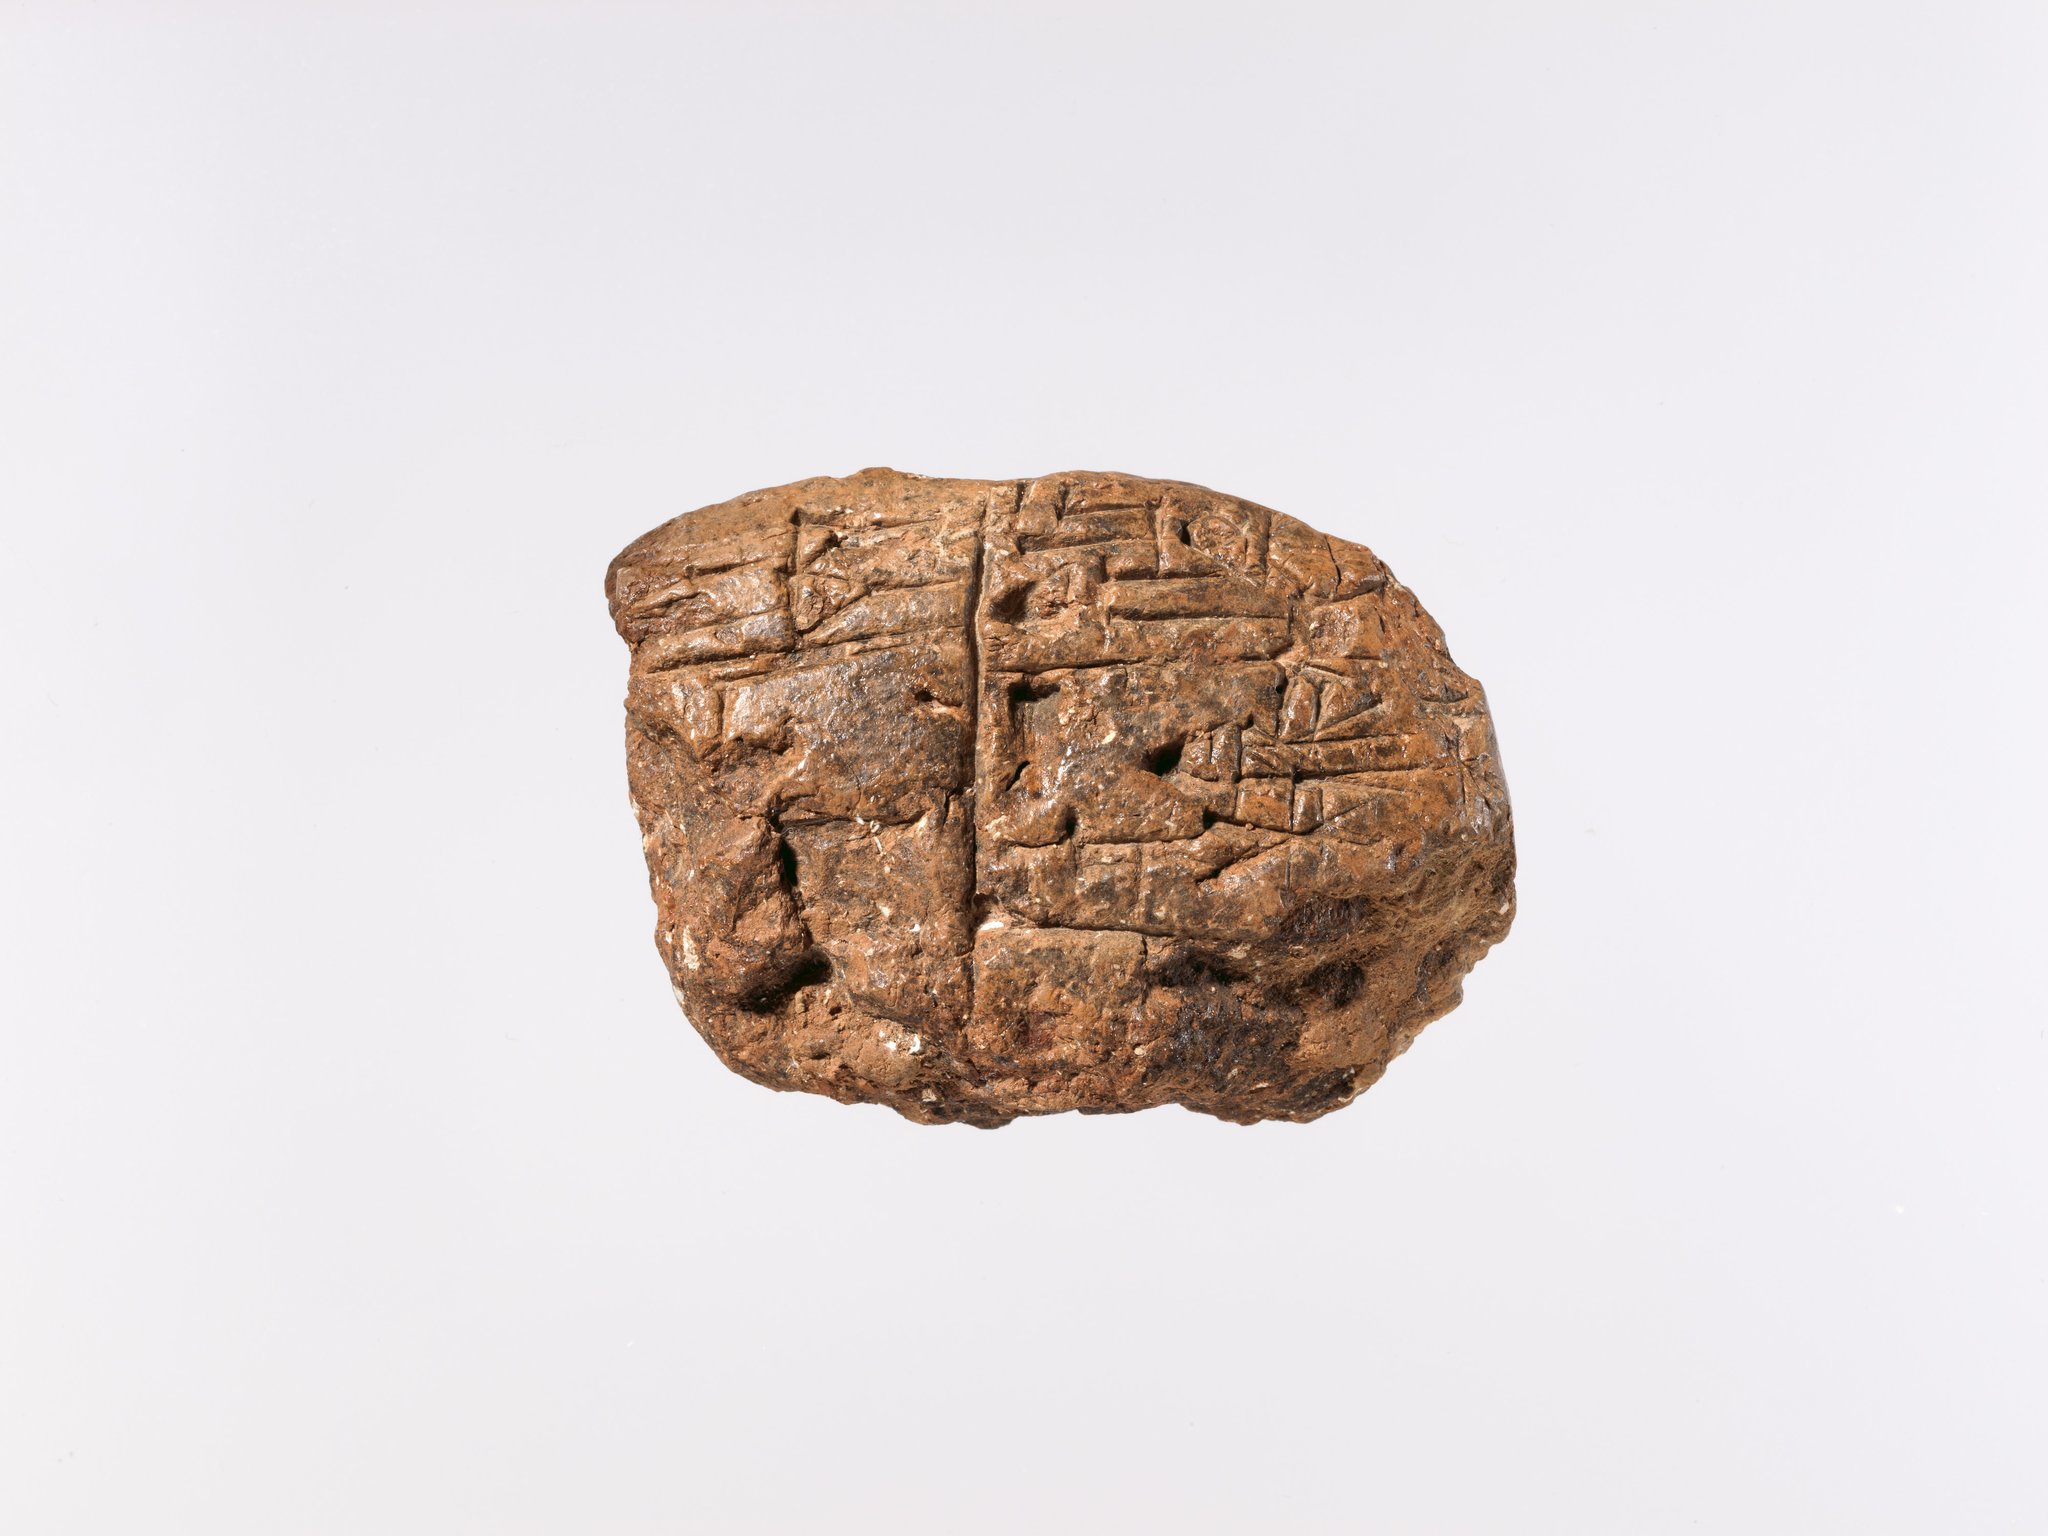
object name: cuneiform tablet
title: Cuneiform tablet: fragment of an account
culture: sumerian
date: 2600-2350 BCE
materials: clay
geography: mesopotamia